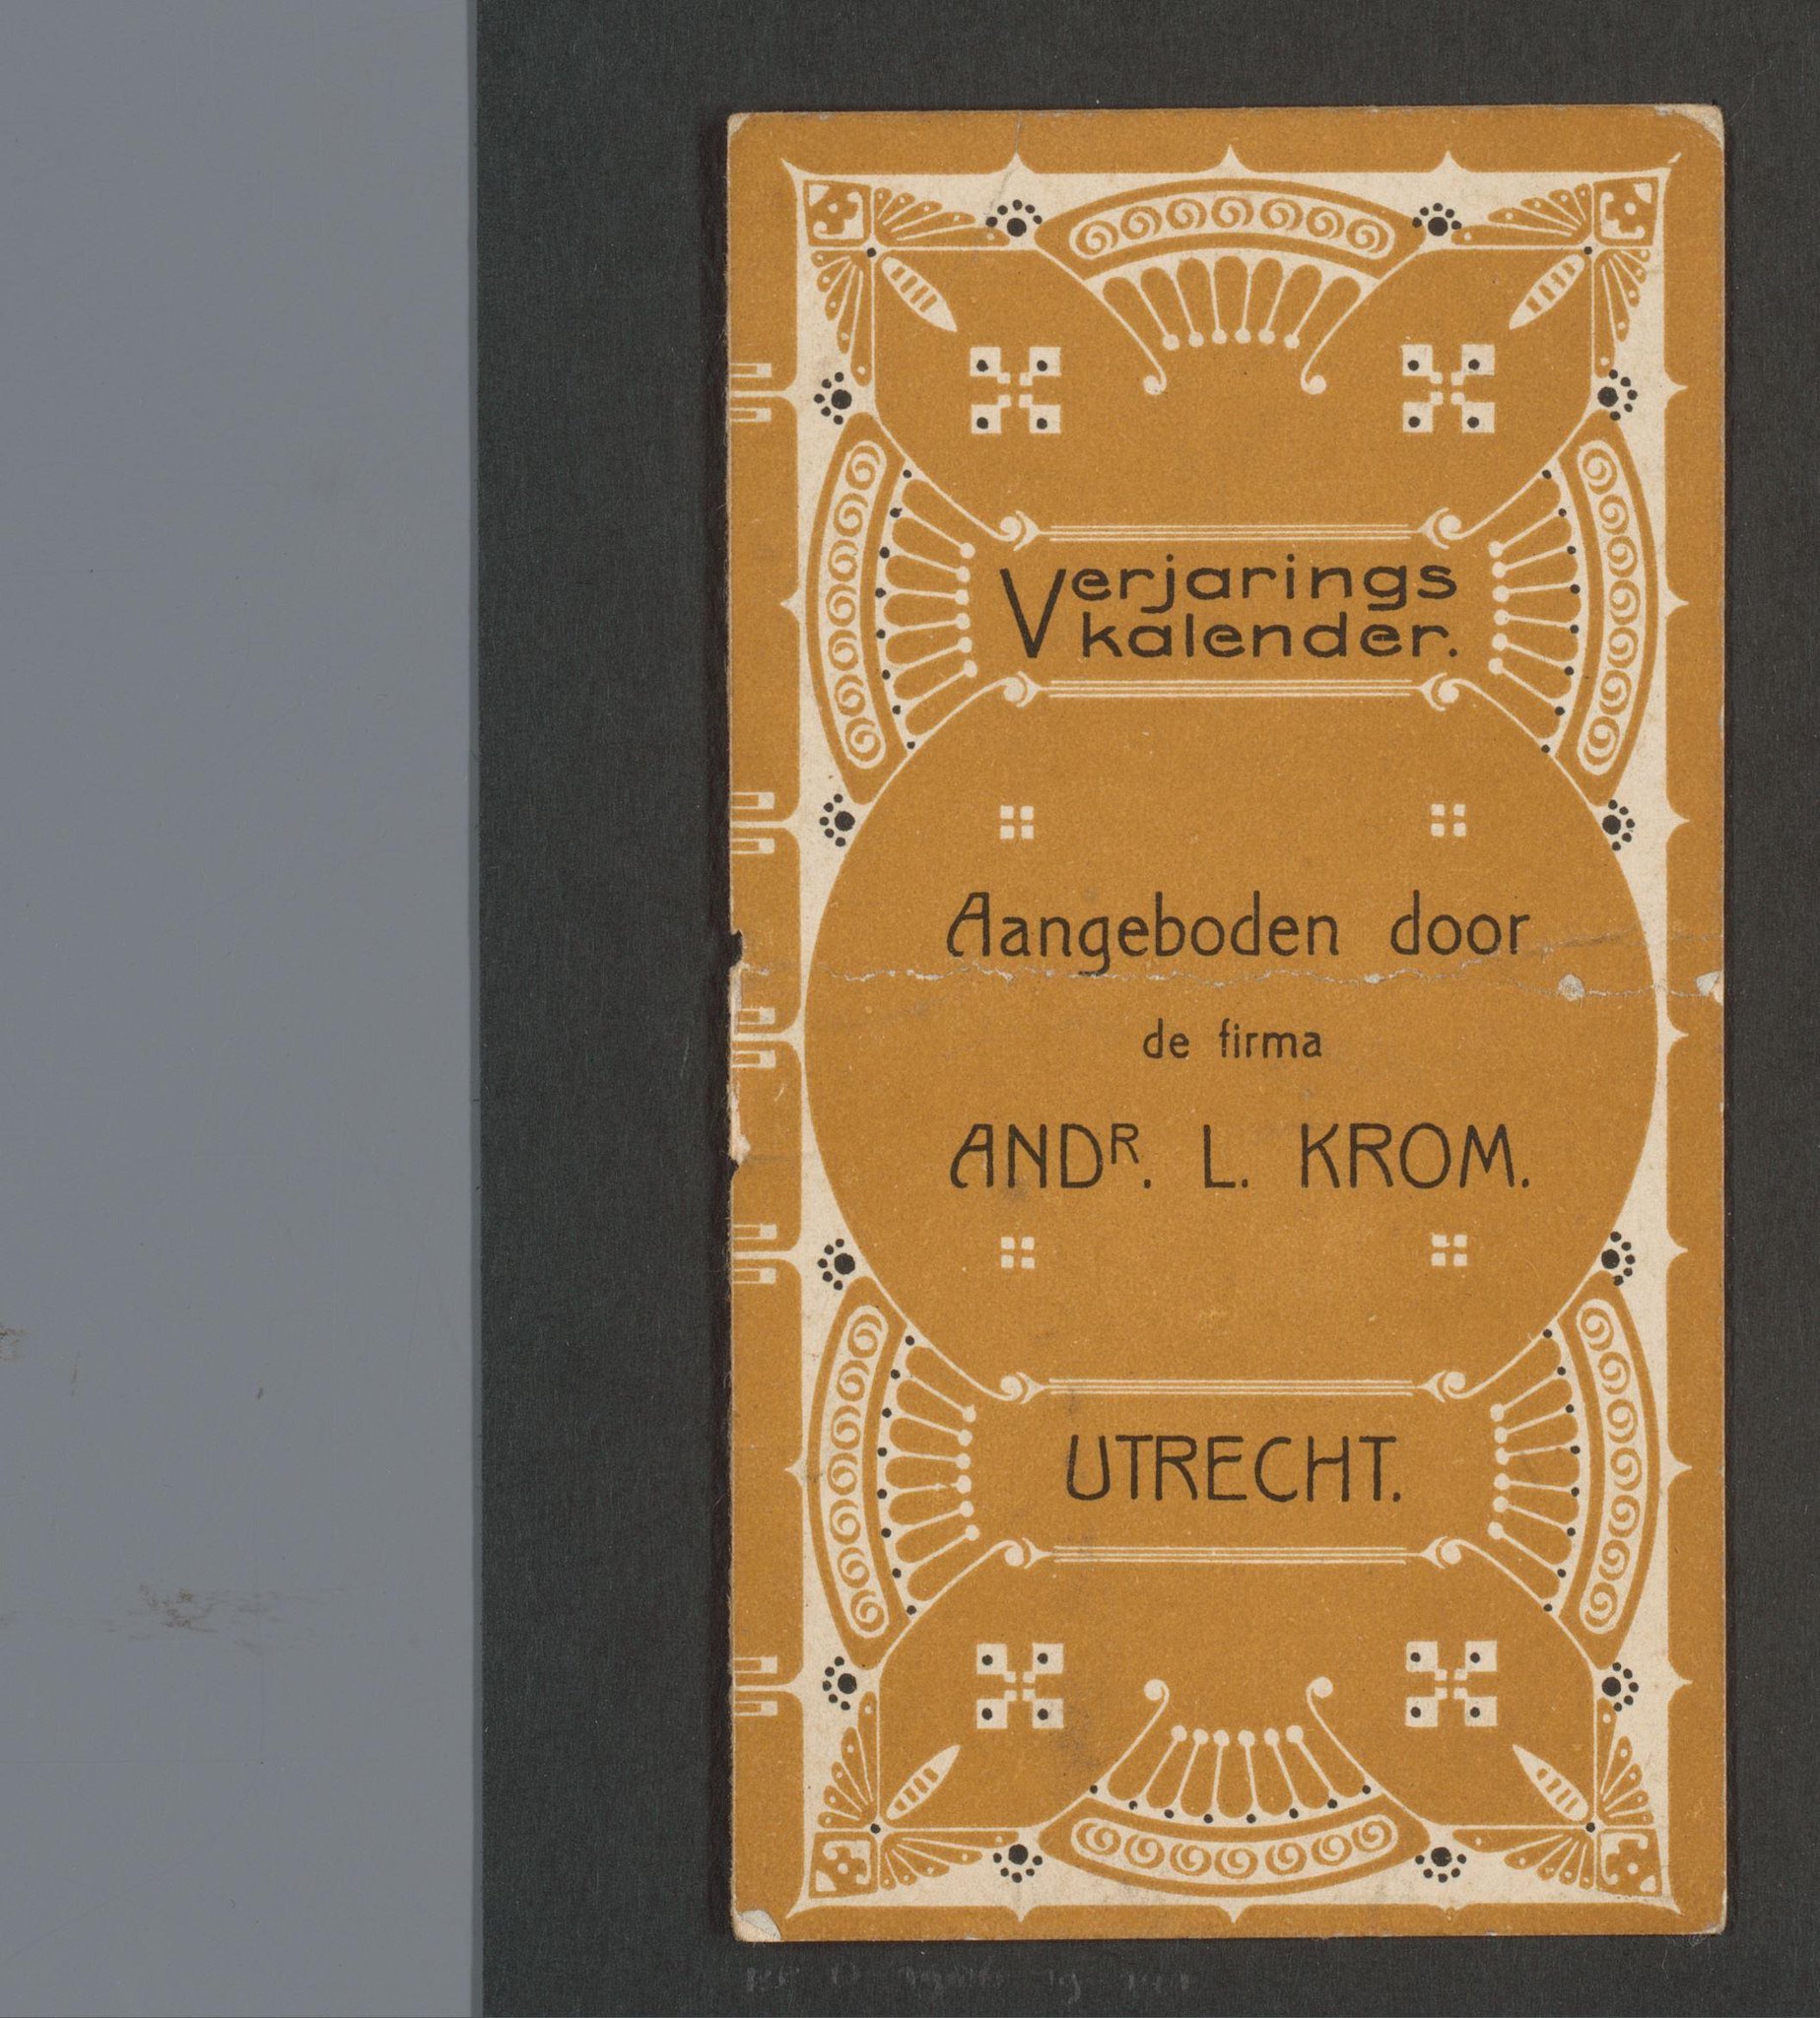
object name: photomechanical print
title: Voorzijde van de omslag van een verjaringskalender van de firma Andr. L. Krom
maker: reinier willem petrus de vries (1874-1953)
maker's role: draughtsman, print maker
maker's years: 1874-1953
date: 1884-1952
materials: paper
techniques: printing block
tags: ornaments ~ art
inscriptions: collector's mark: ‘R:MVS.’